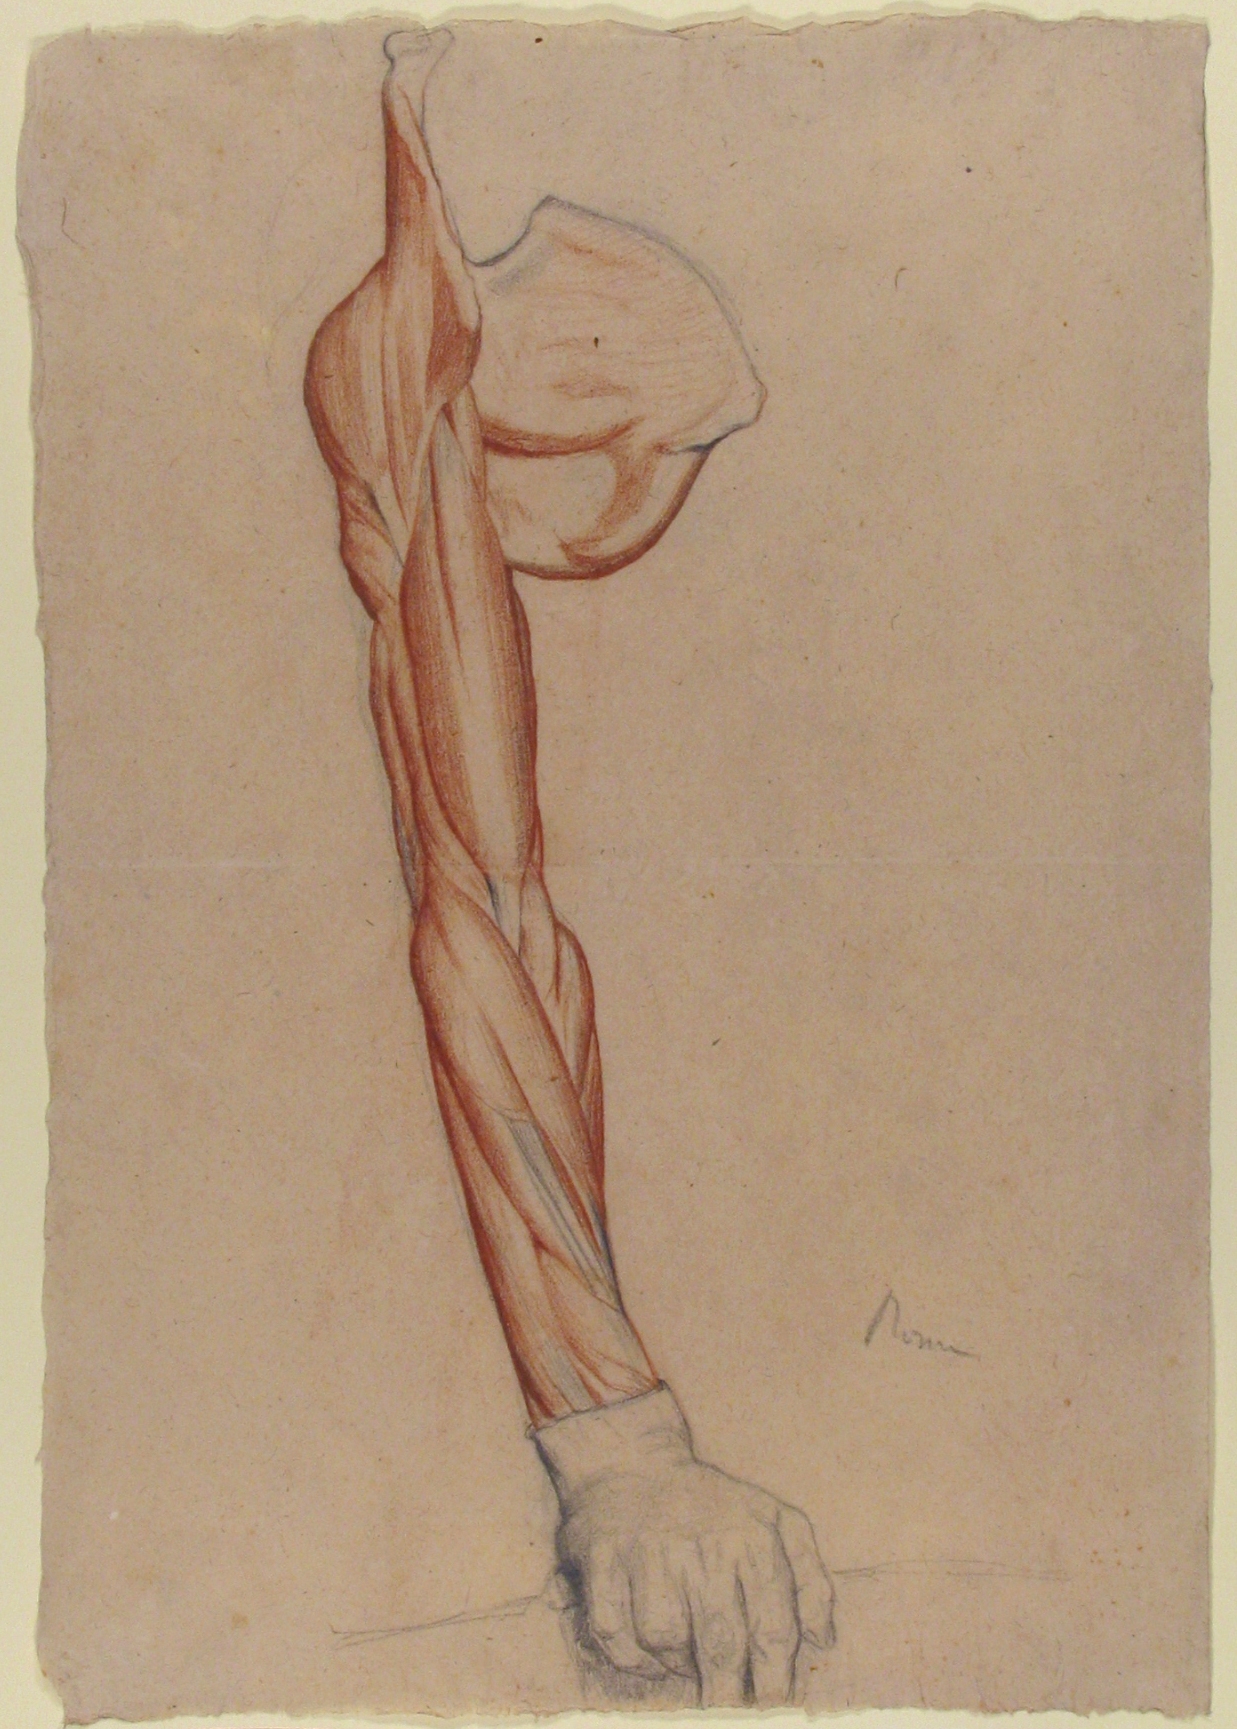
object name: drawing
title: Ecorché: Right Arm and Shoulder Blade with Right Hand Intact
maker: edgar degas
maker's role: artist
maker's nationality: french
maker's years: 1834-1917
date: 1857-1858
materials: chalk, charcoal